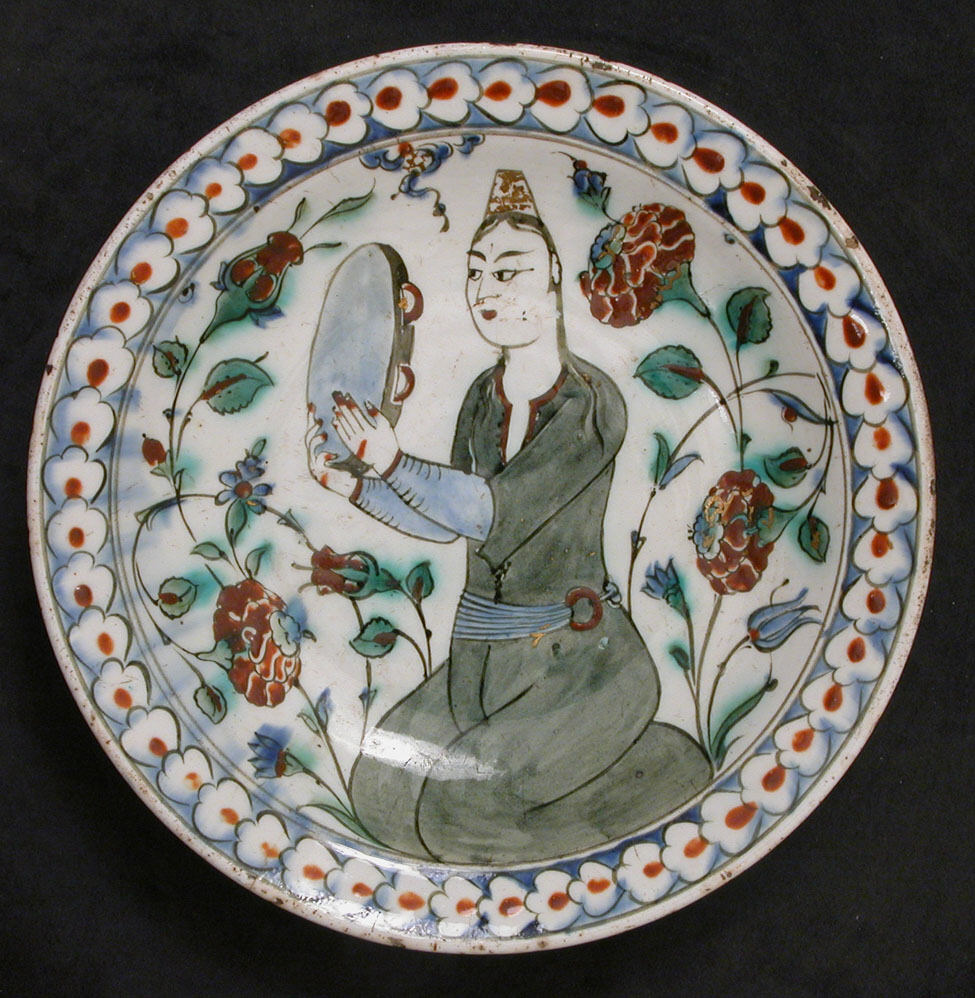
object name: plate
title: Plate Depicting a Woman Playing Tambourine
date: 1600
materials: glaze, stonepaste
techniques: painting, polychrome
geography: turkey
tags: musical instruments,women